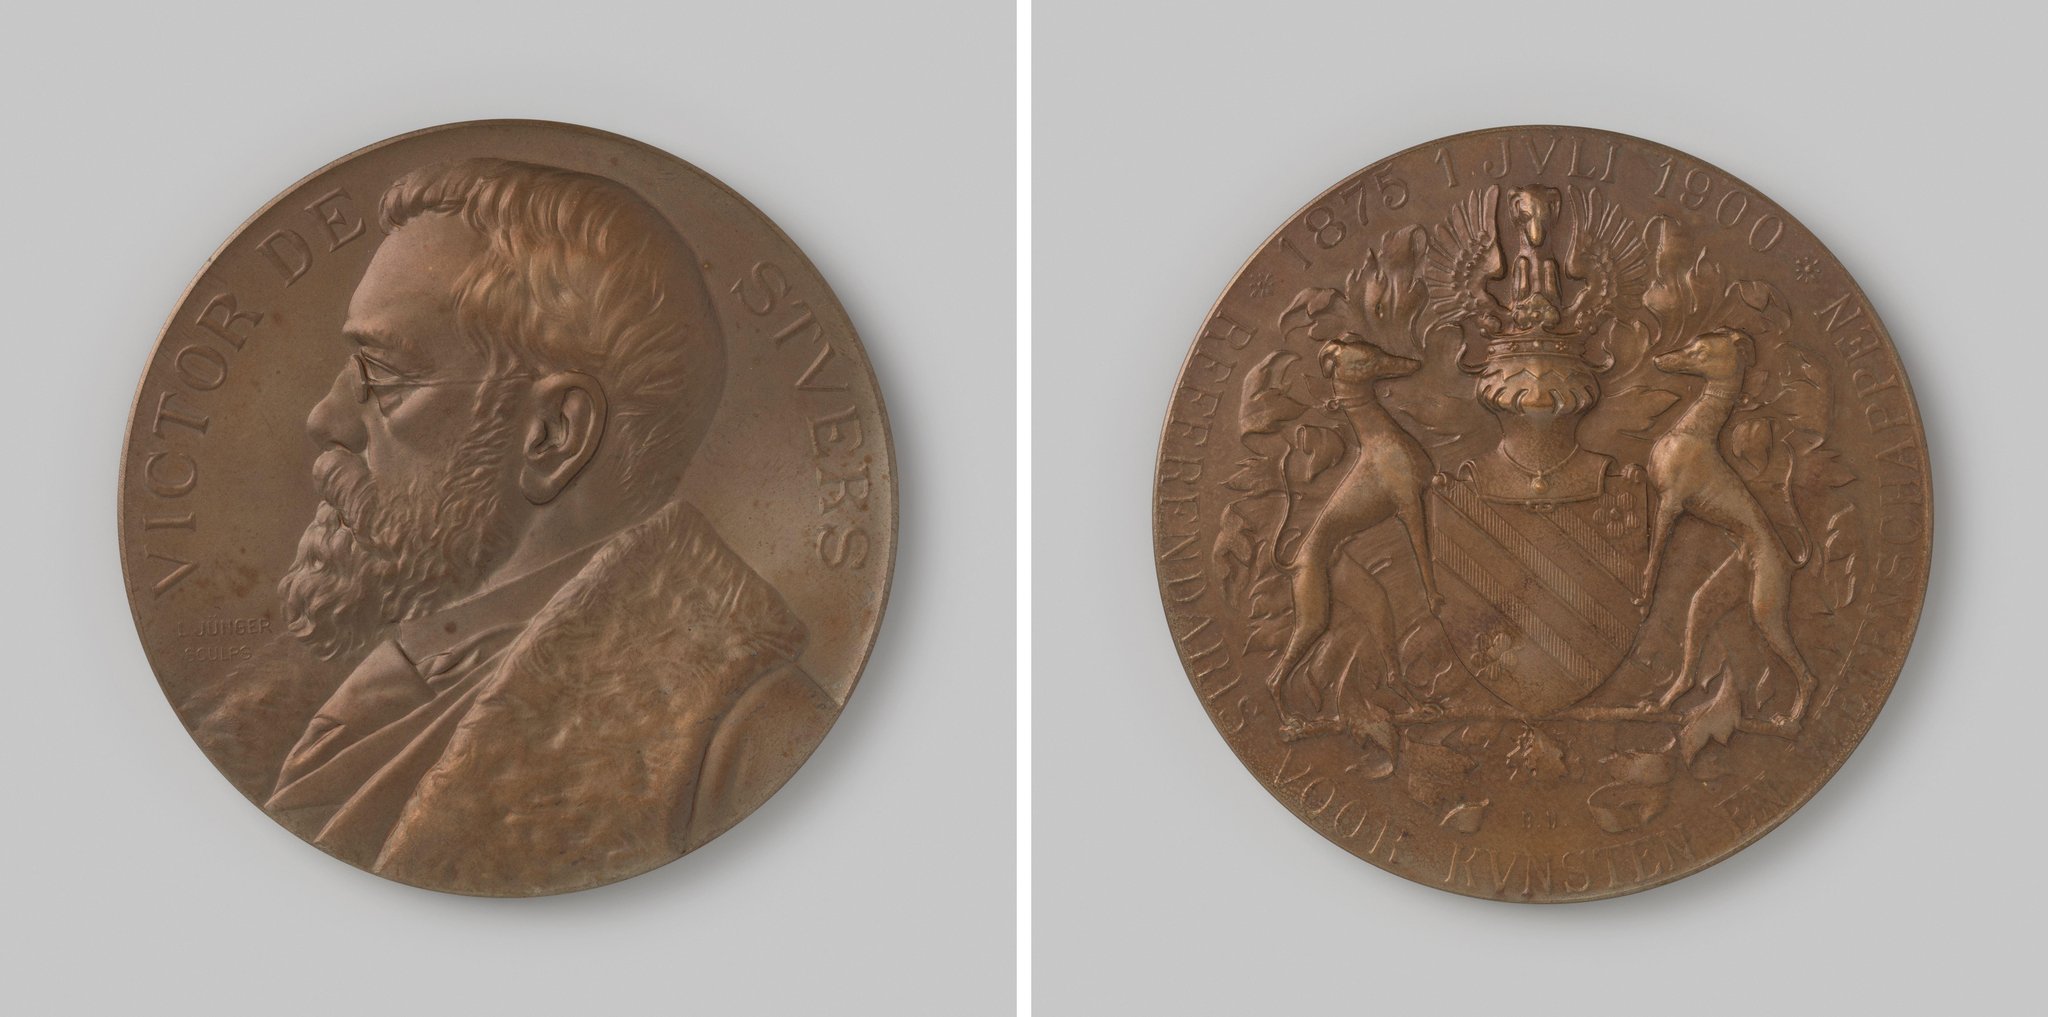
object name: history medal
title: Vijfentwitigjarig jubileum van Victor de Stuers als referendaris voor kunsten en wetenschappen 1875-1900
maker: ludwig jünger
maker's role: medailleur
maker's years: 1857-1908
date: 1900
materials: bronze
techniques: striking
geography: utrecht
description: Bronzen penning, op de voorzijde het borstbeeld van De Stuers met omschrift, op de keerzijde een gehelmd wapenschild met windhonden als dragers op loofwerk, met omschrift.